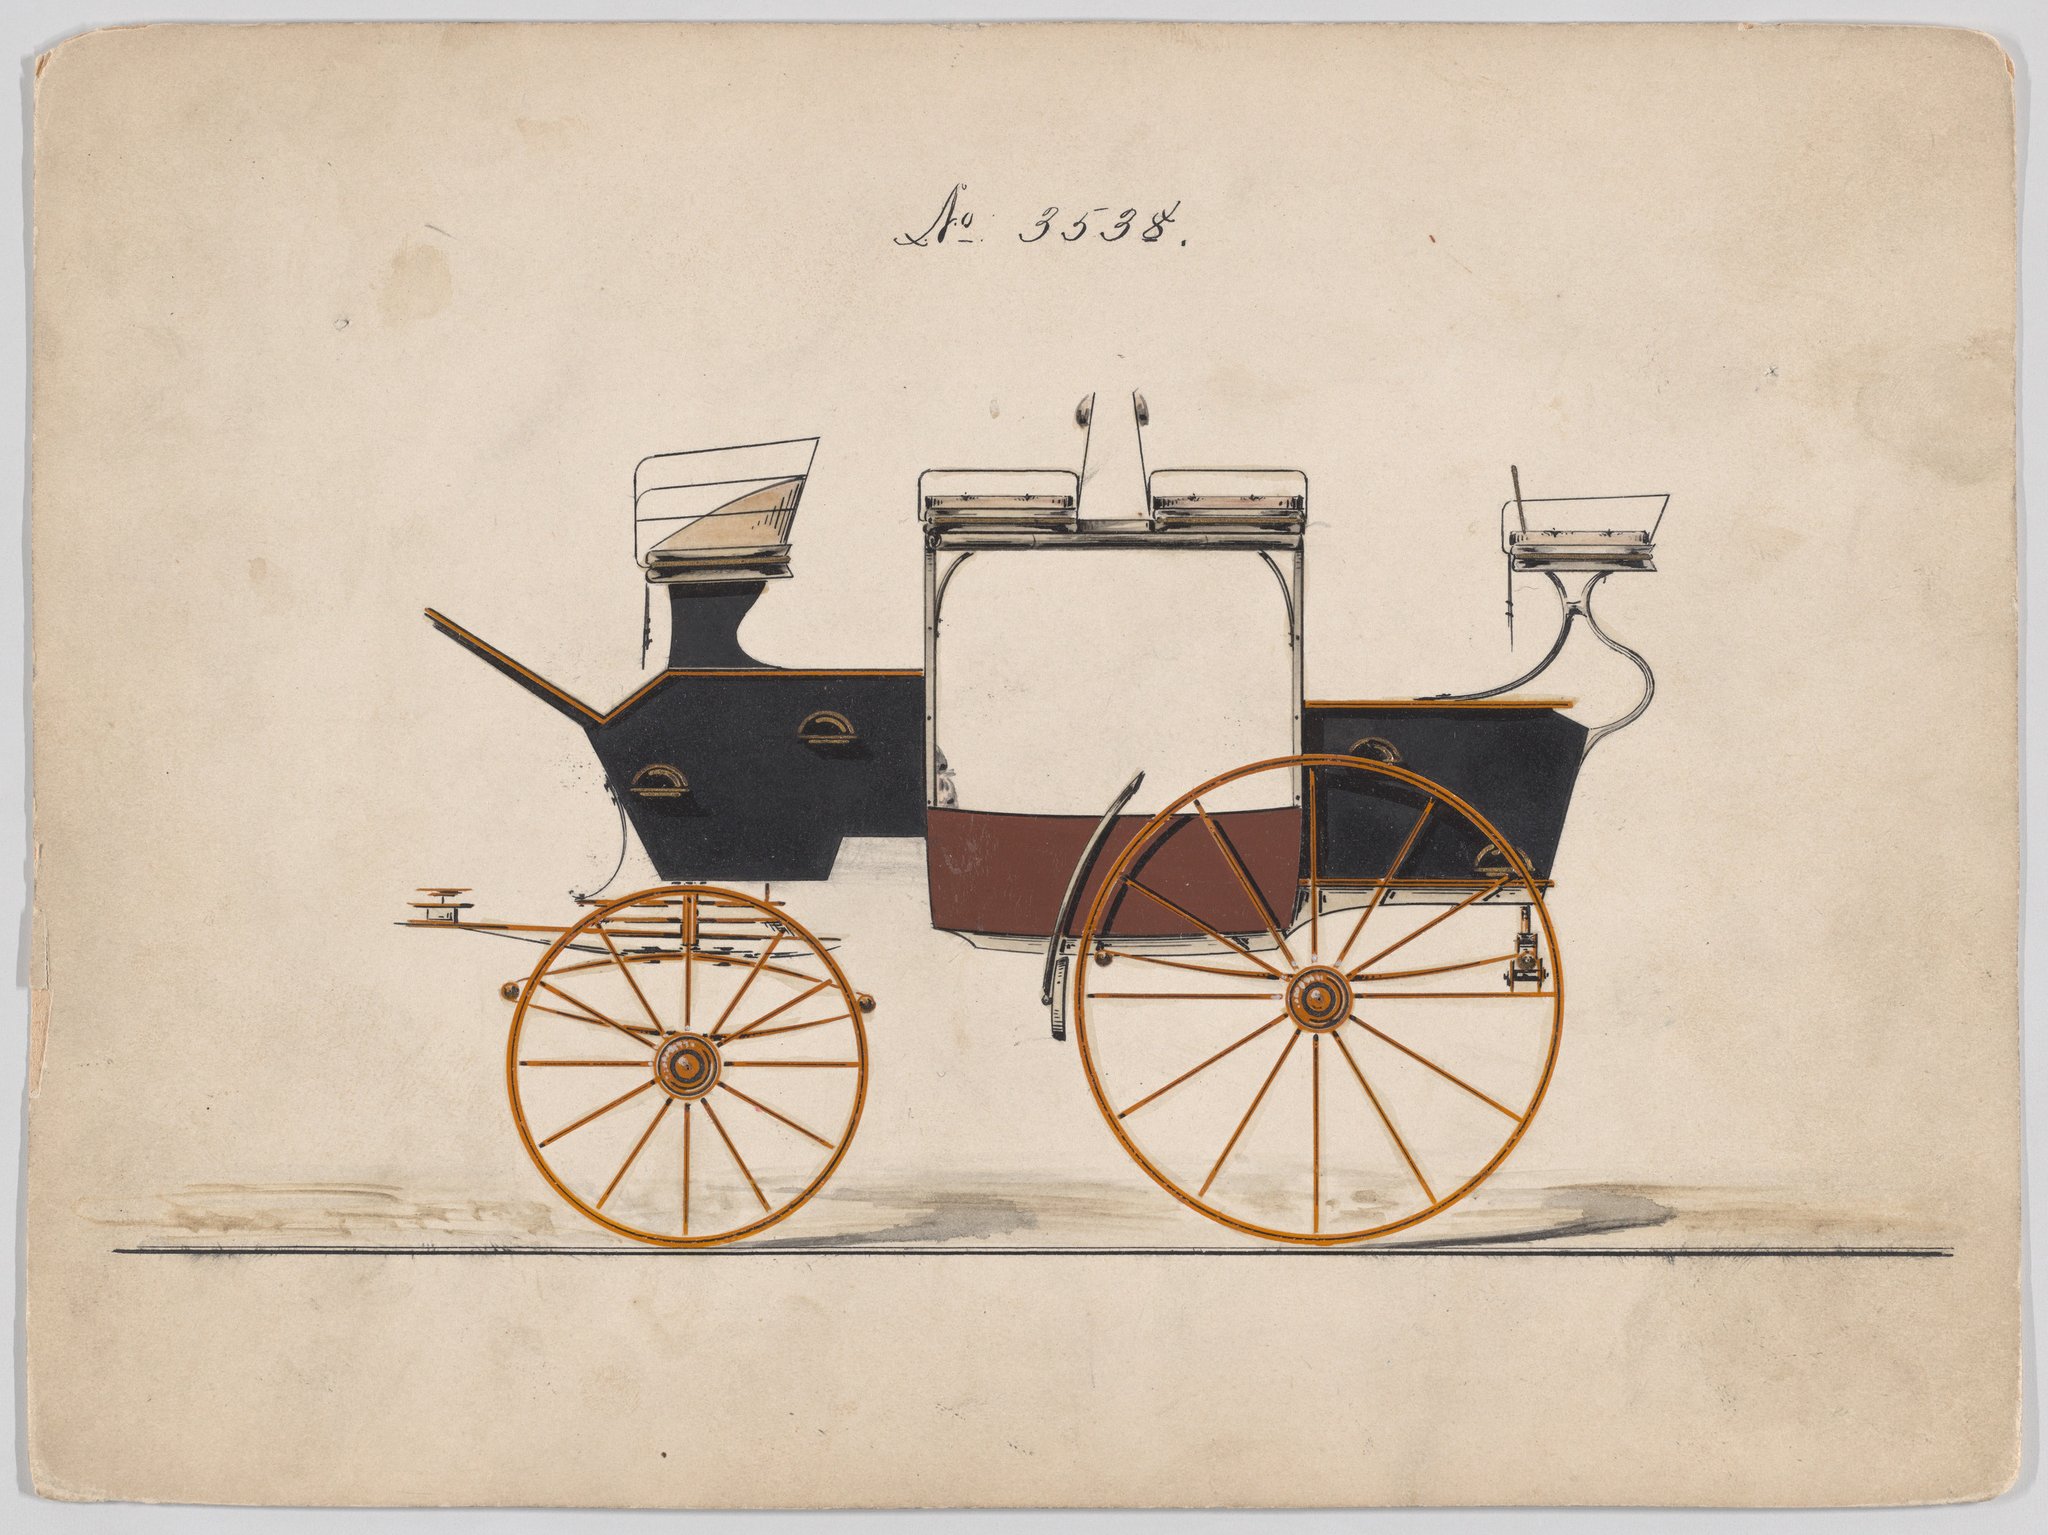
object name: drawing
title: Open Coach #3538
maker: brewster & co.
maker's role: manufacturer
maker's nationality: american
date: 1879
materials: gouache, gum arabic, ink, watercolor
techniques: pen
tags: carriages